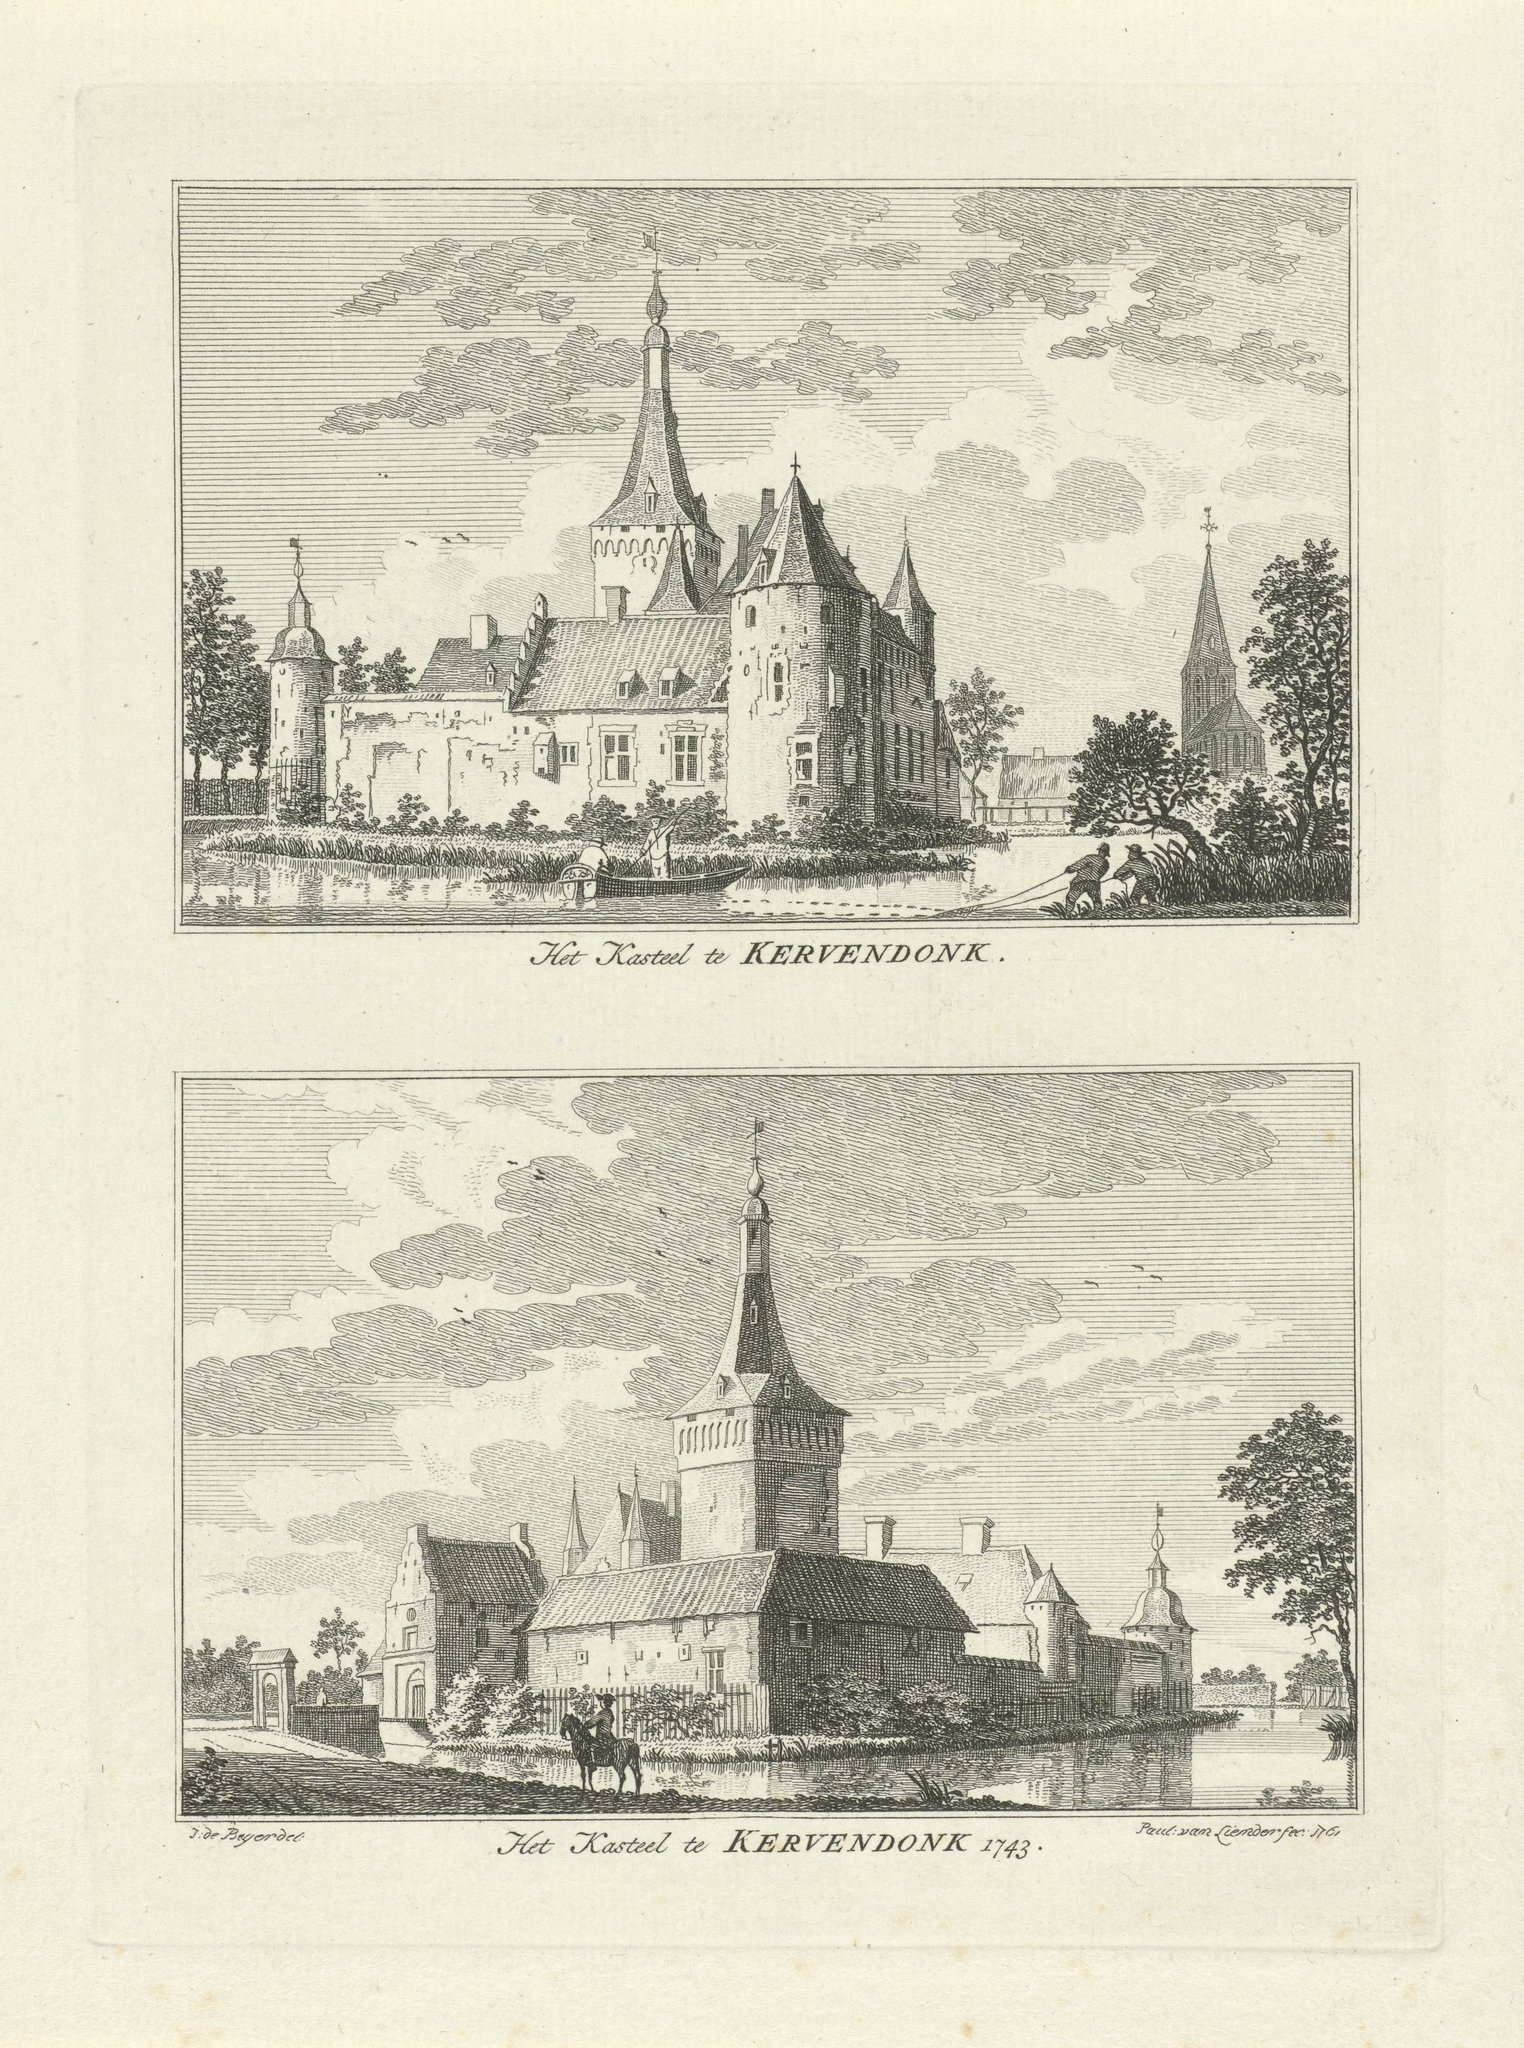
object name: print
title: Dorps- en stadsgezichten te Kleef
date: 1761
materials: paper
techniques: etching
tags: landscape with tower or castle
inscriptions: collector's mark: Lugt 240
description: Twee voorstellingen van één plaat. Twee gezichten op de burcht te Kervenheim. De prent maakt deel uit van een 100-delige serie met gezichten op dorpen en steden in en nabij Kleef.